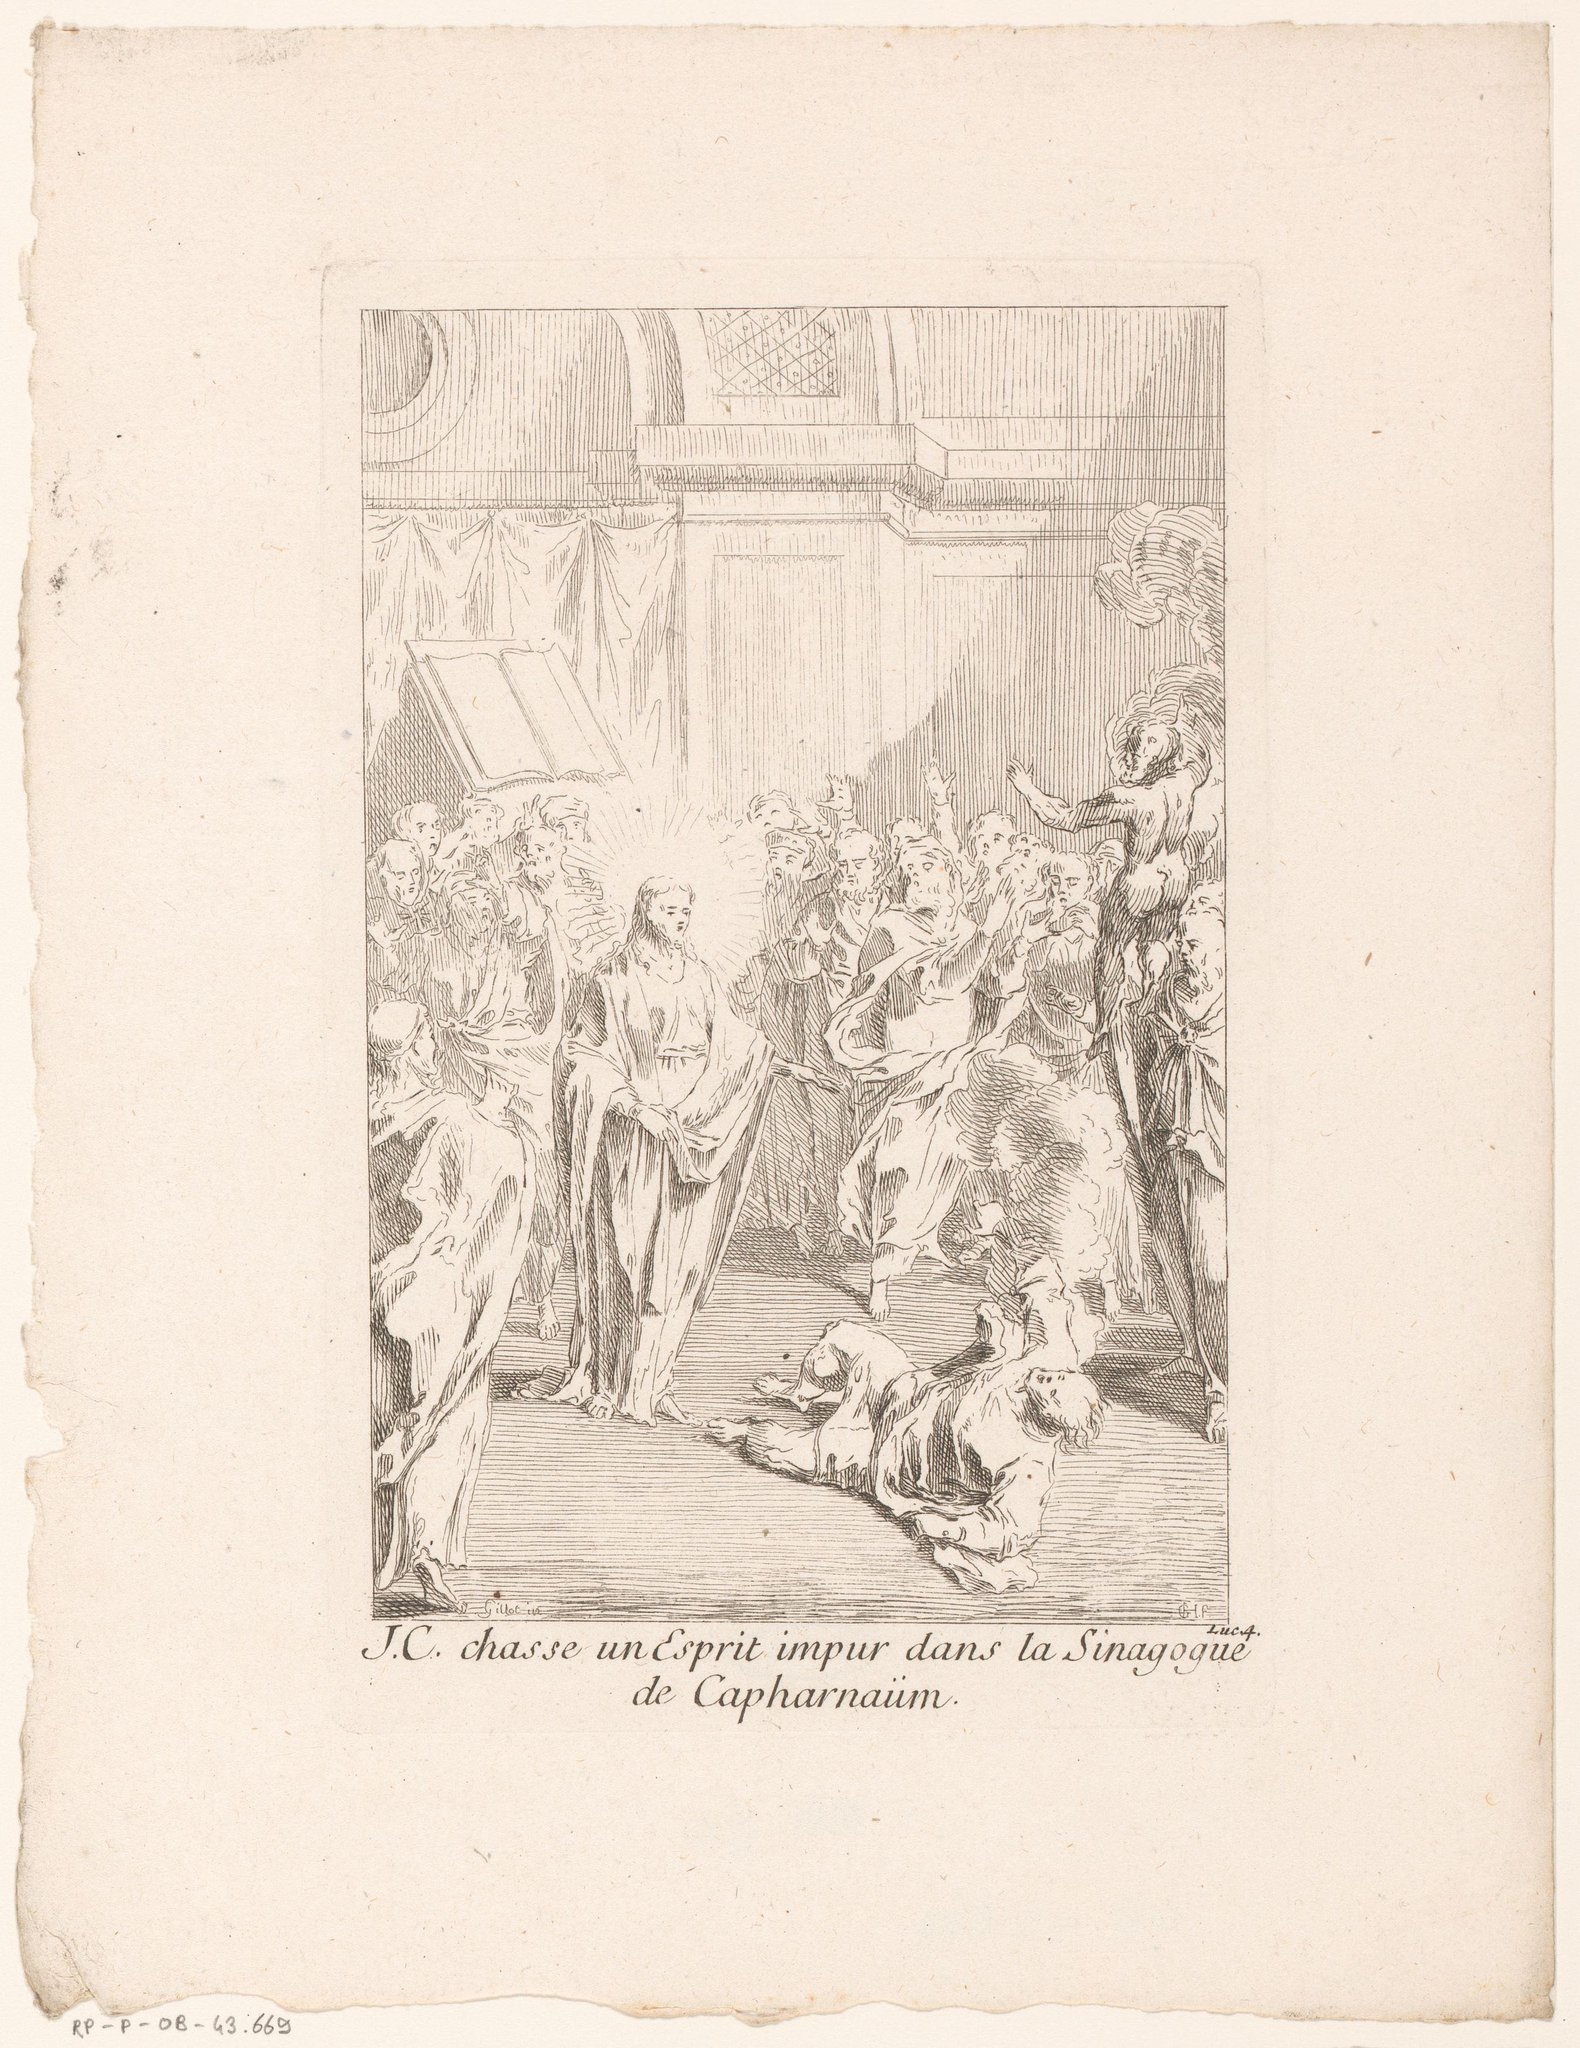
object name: print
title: La Vie de N.S. Jesus C.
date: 1705-1732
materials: paper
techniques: etching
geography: france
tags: healing of a possessed man in a synagogue (mark 1:23-28; luke 4:33-37)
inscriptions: collector's mark: Lugt 2228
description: Maakt deel uit van een serie met zestig prenten met als thema het leven van Christus.